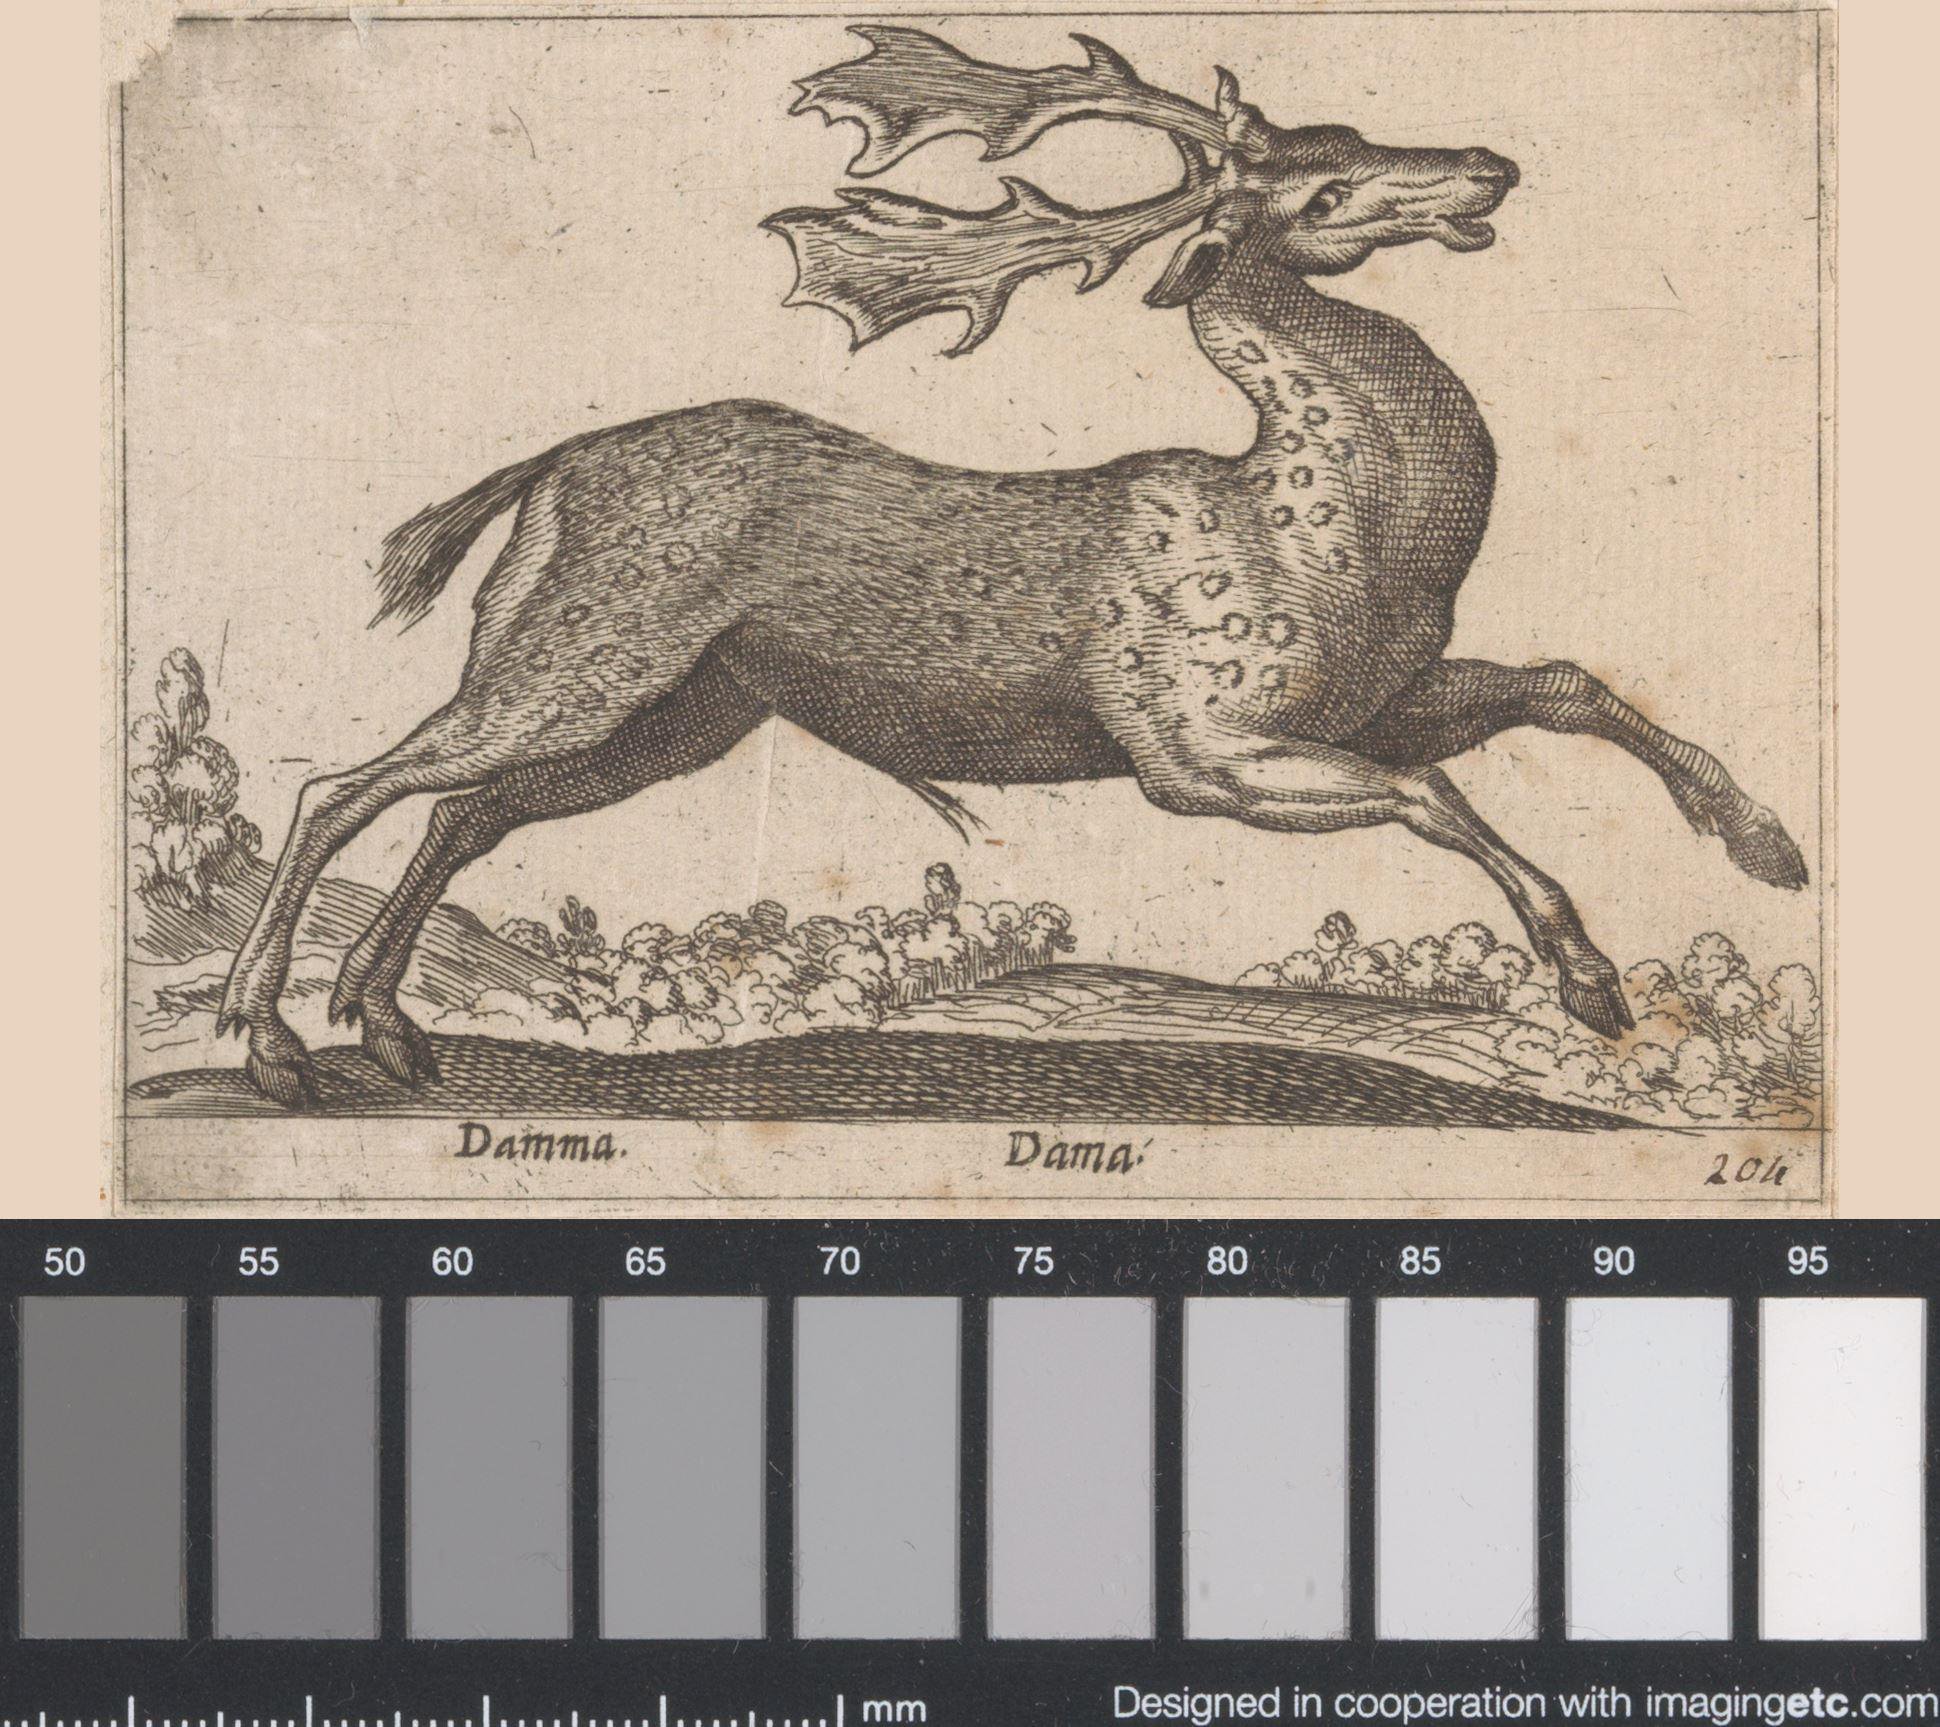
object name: print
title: Dieren en fabelwezens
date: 1565-1630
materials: paper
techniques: etching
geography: vatican city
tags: hoofed animals: stag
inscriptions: number: ‘204’, collector's mark: Lugt 11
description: Deze prent maakt deel uit van een reeks prenten van dieren door Antonio Tempesta. Bekend is dat een tweede staat (met nummering) van deze serie is uitgegeven door Giovanni Giacomo de' Rossi in 1650. Onbekend is wie de eerste staat heeft uitgegeven en wanneer.